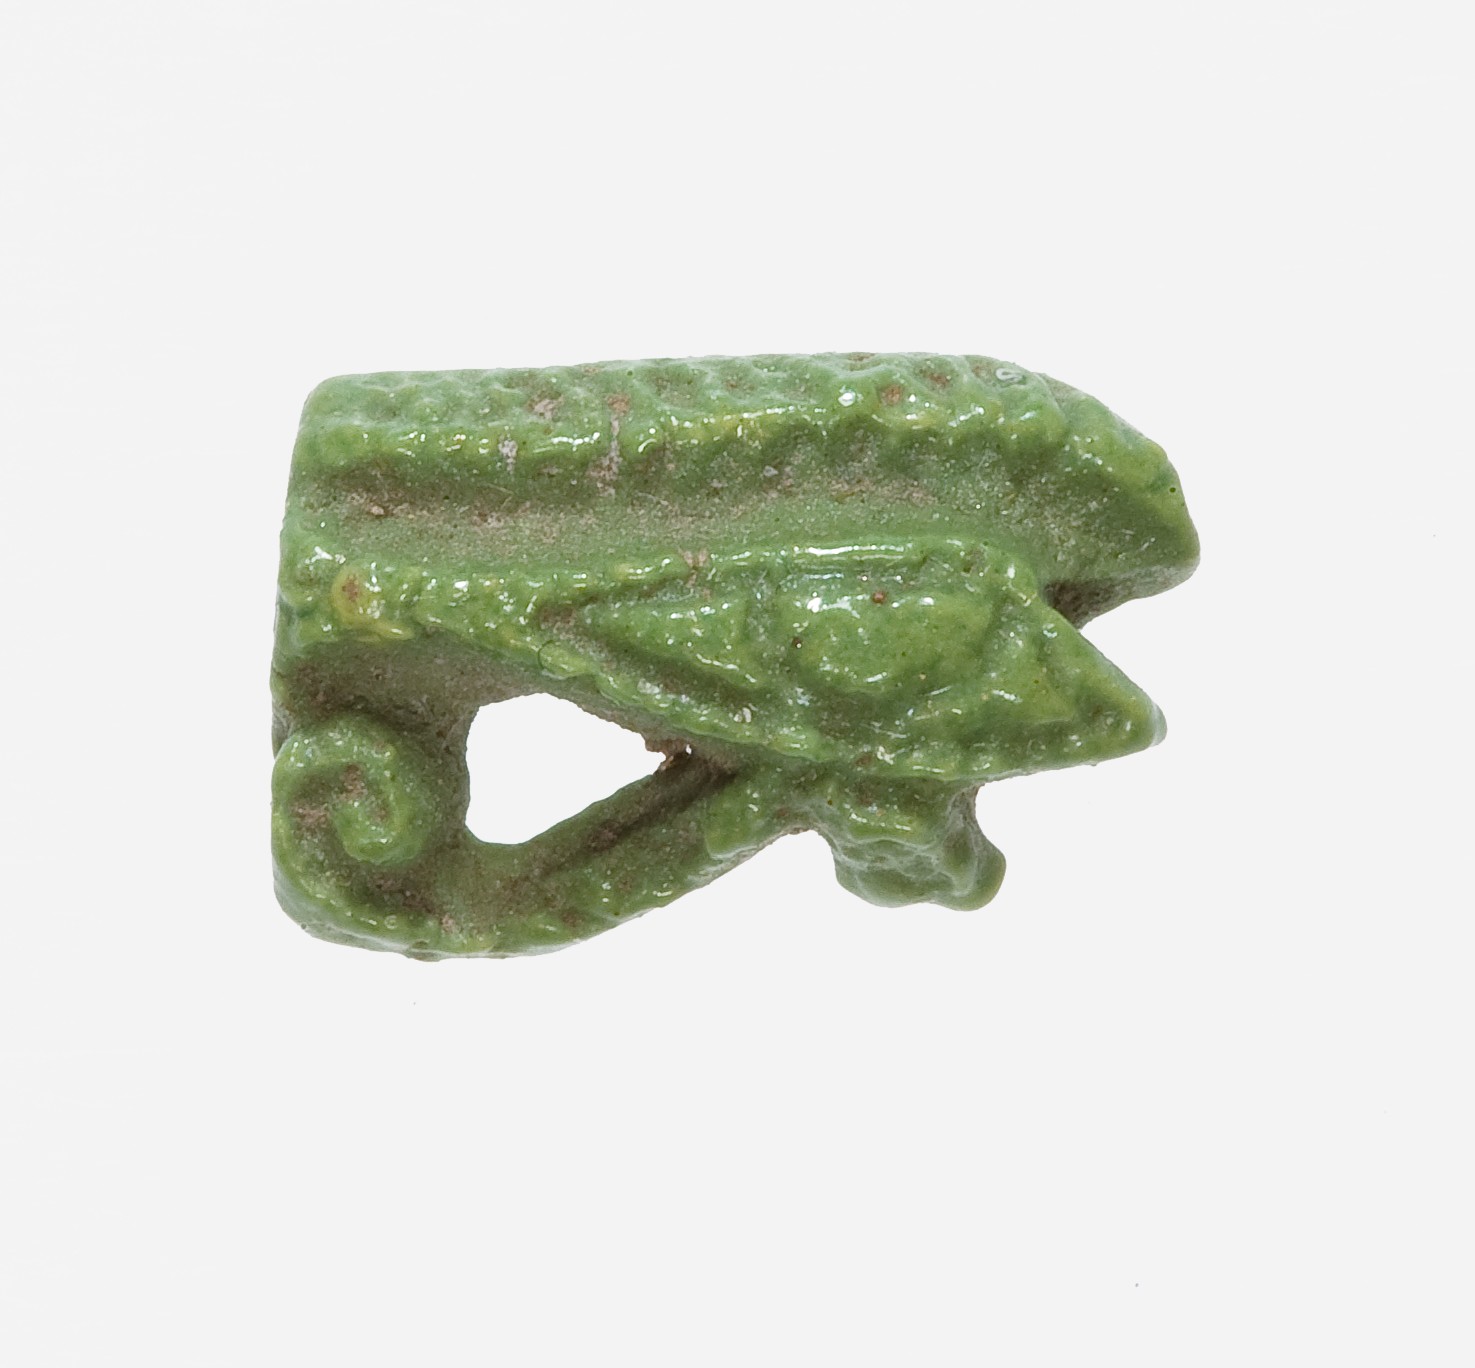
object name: amulet, wedjat eye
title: Sacred Eye Amulet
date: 1390-1352 BCE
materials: faience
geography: egypt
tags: eyes